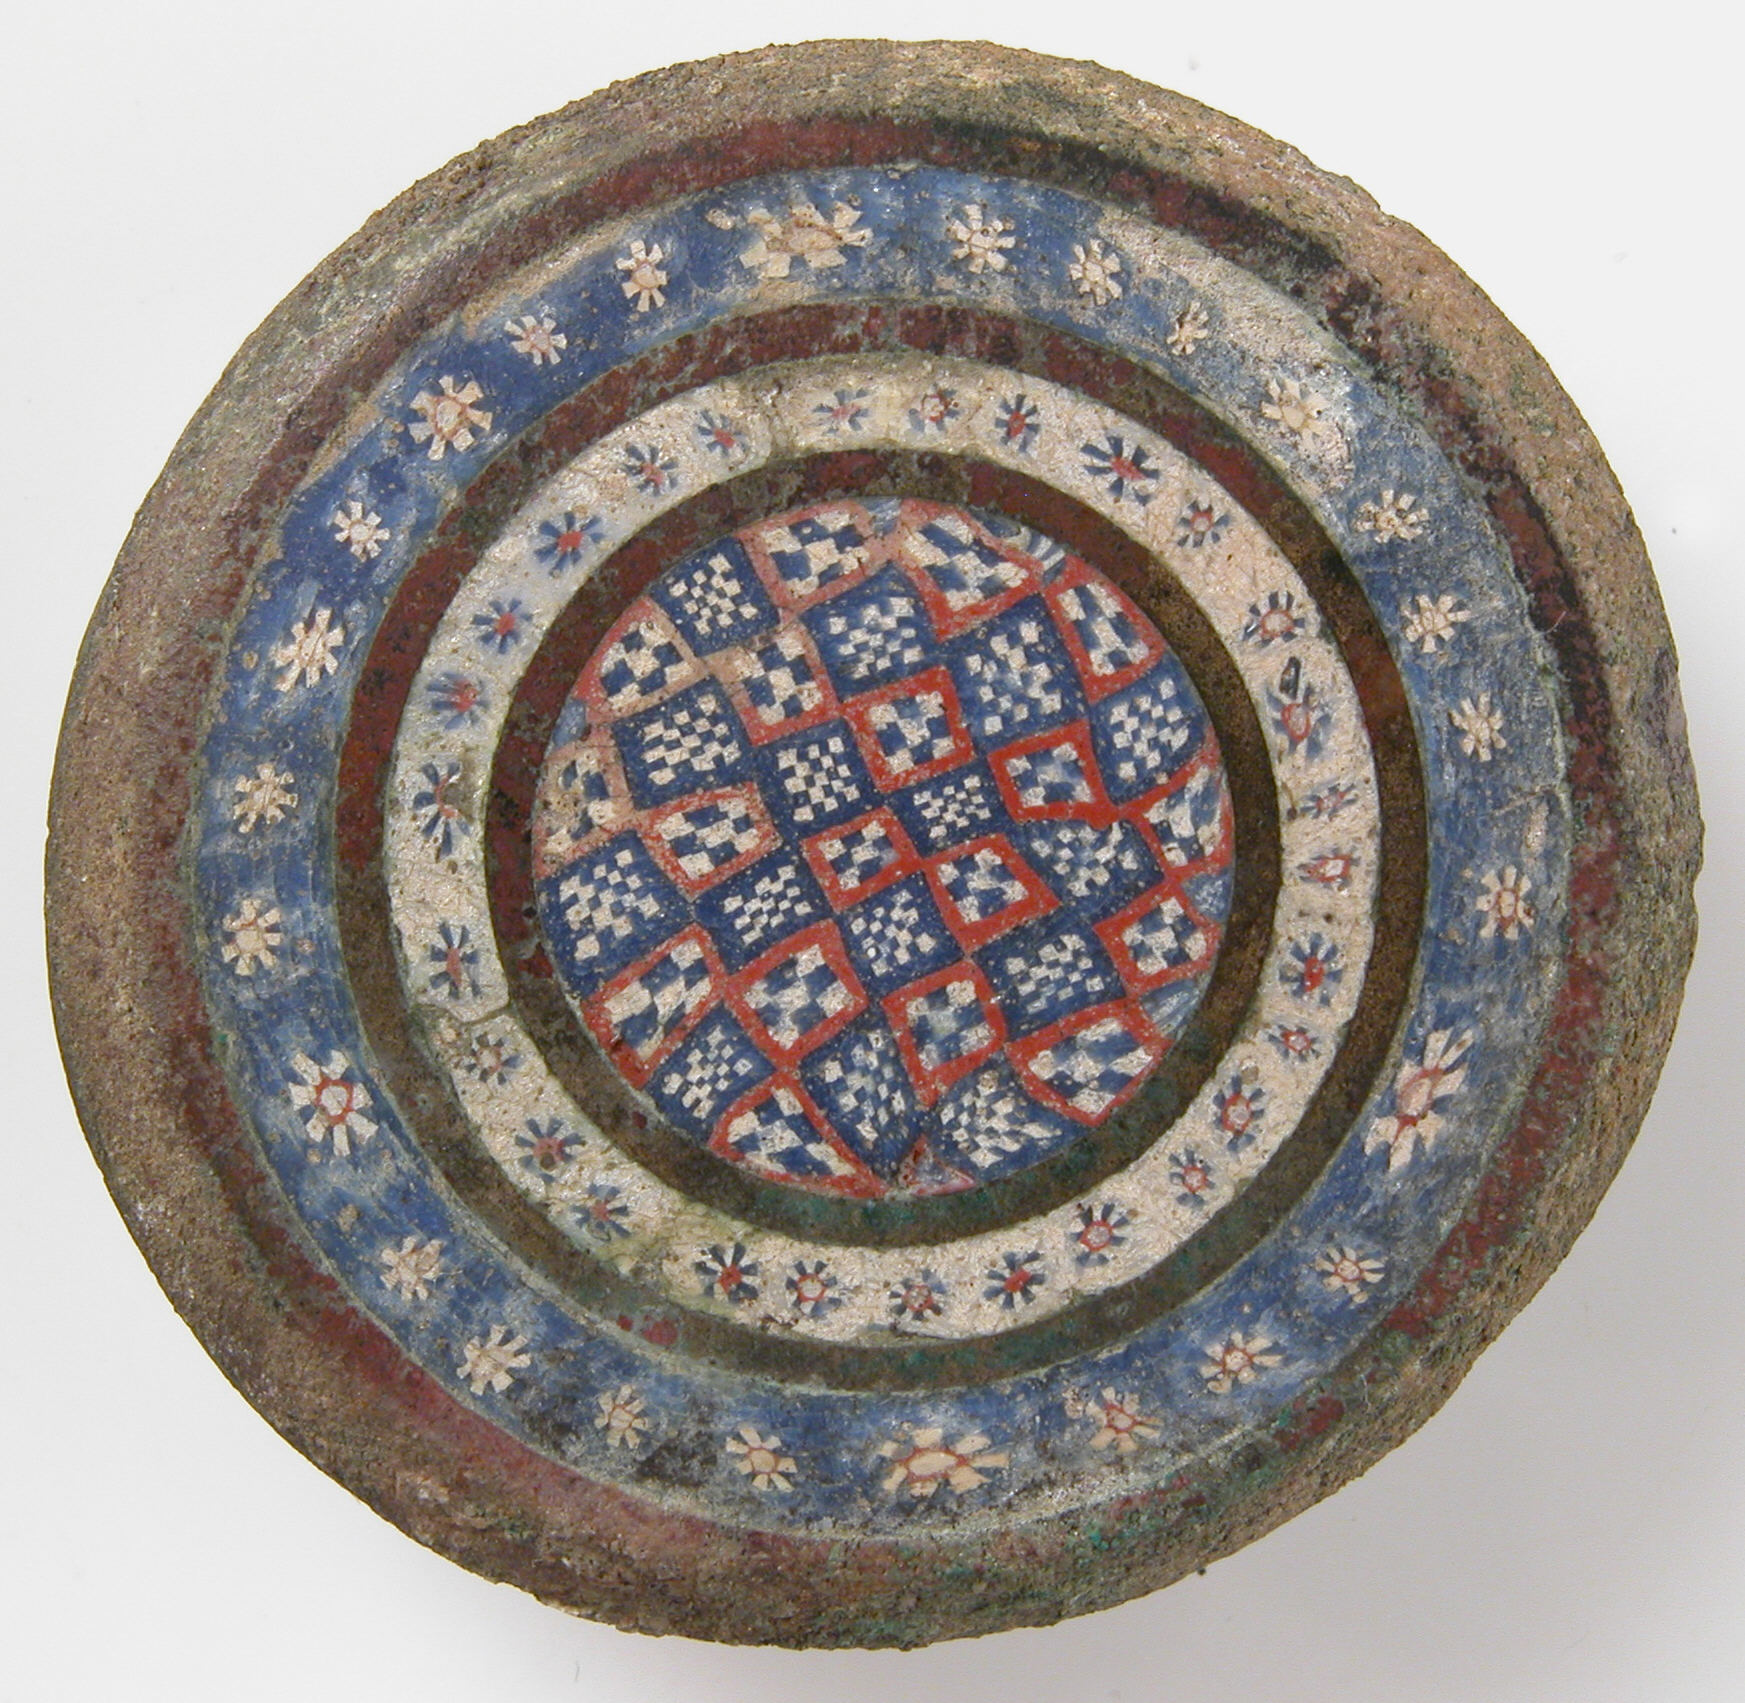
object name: brooch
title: Disk Brooch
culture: roman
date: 101-300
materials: bronze, enamel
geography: gaul